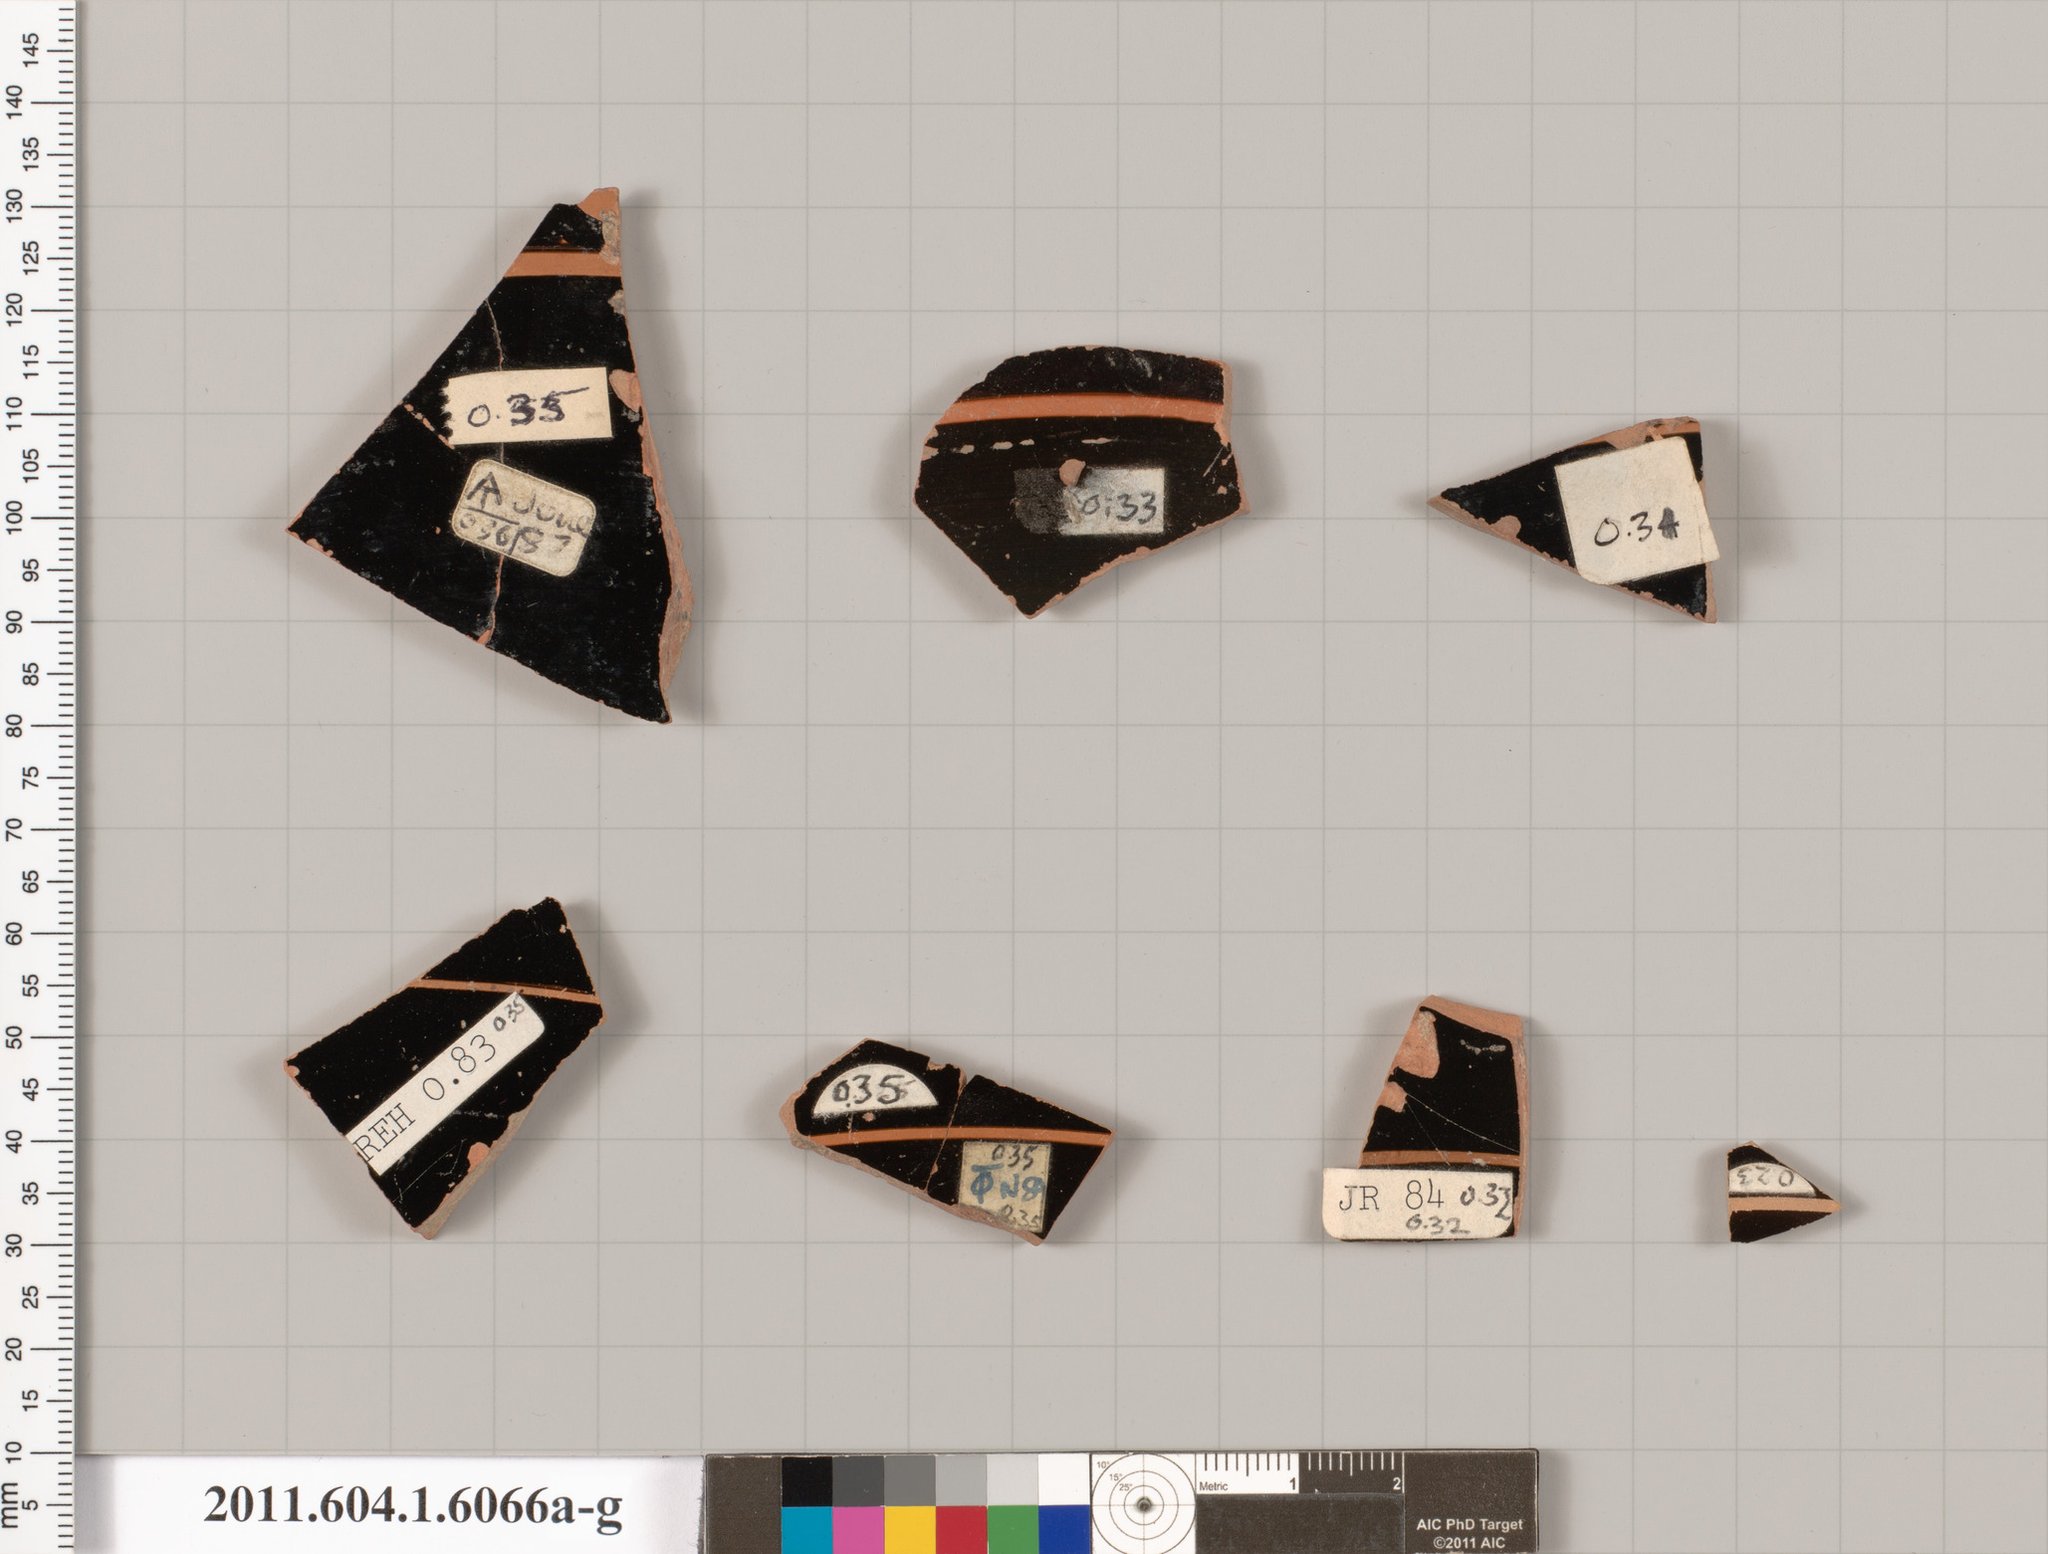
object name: kylix fragment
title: Terracotta fragments of kylikes (drinking cups)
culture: greek, attic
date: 510-500 BCE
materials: terracotta